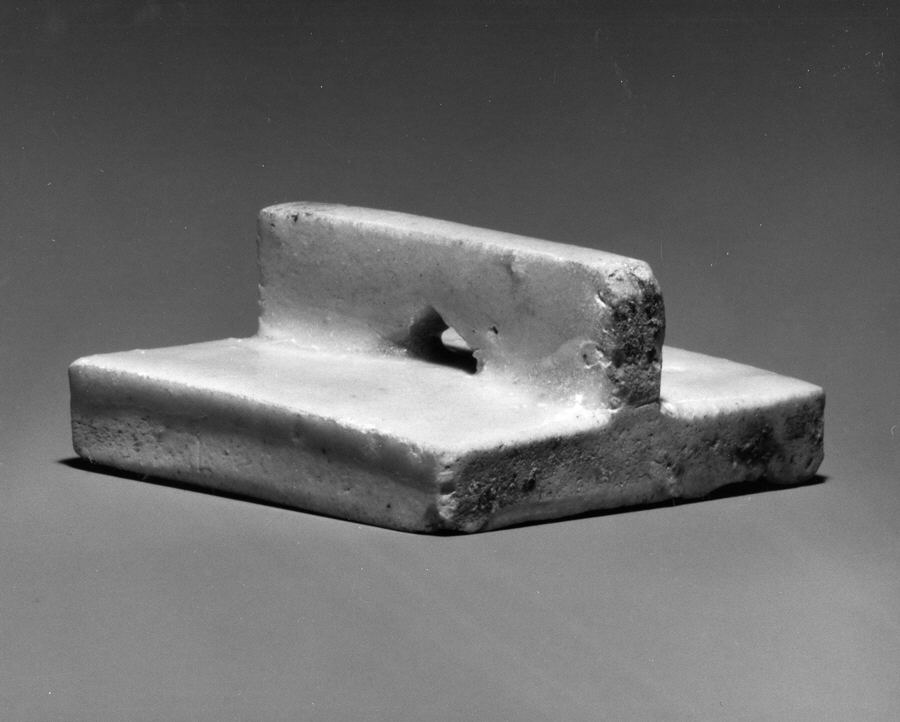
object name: seal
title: Yinqing square seal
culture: chinese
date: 1271-1368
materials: glaze, porcelain